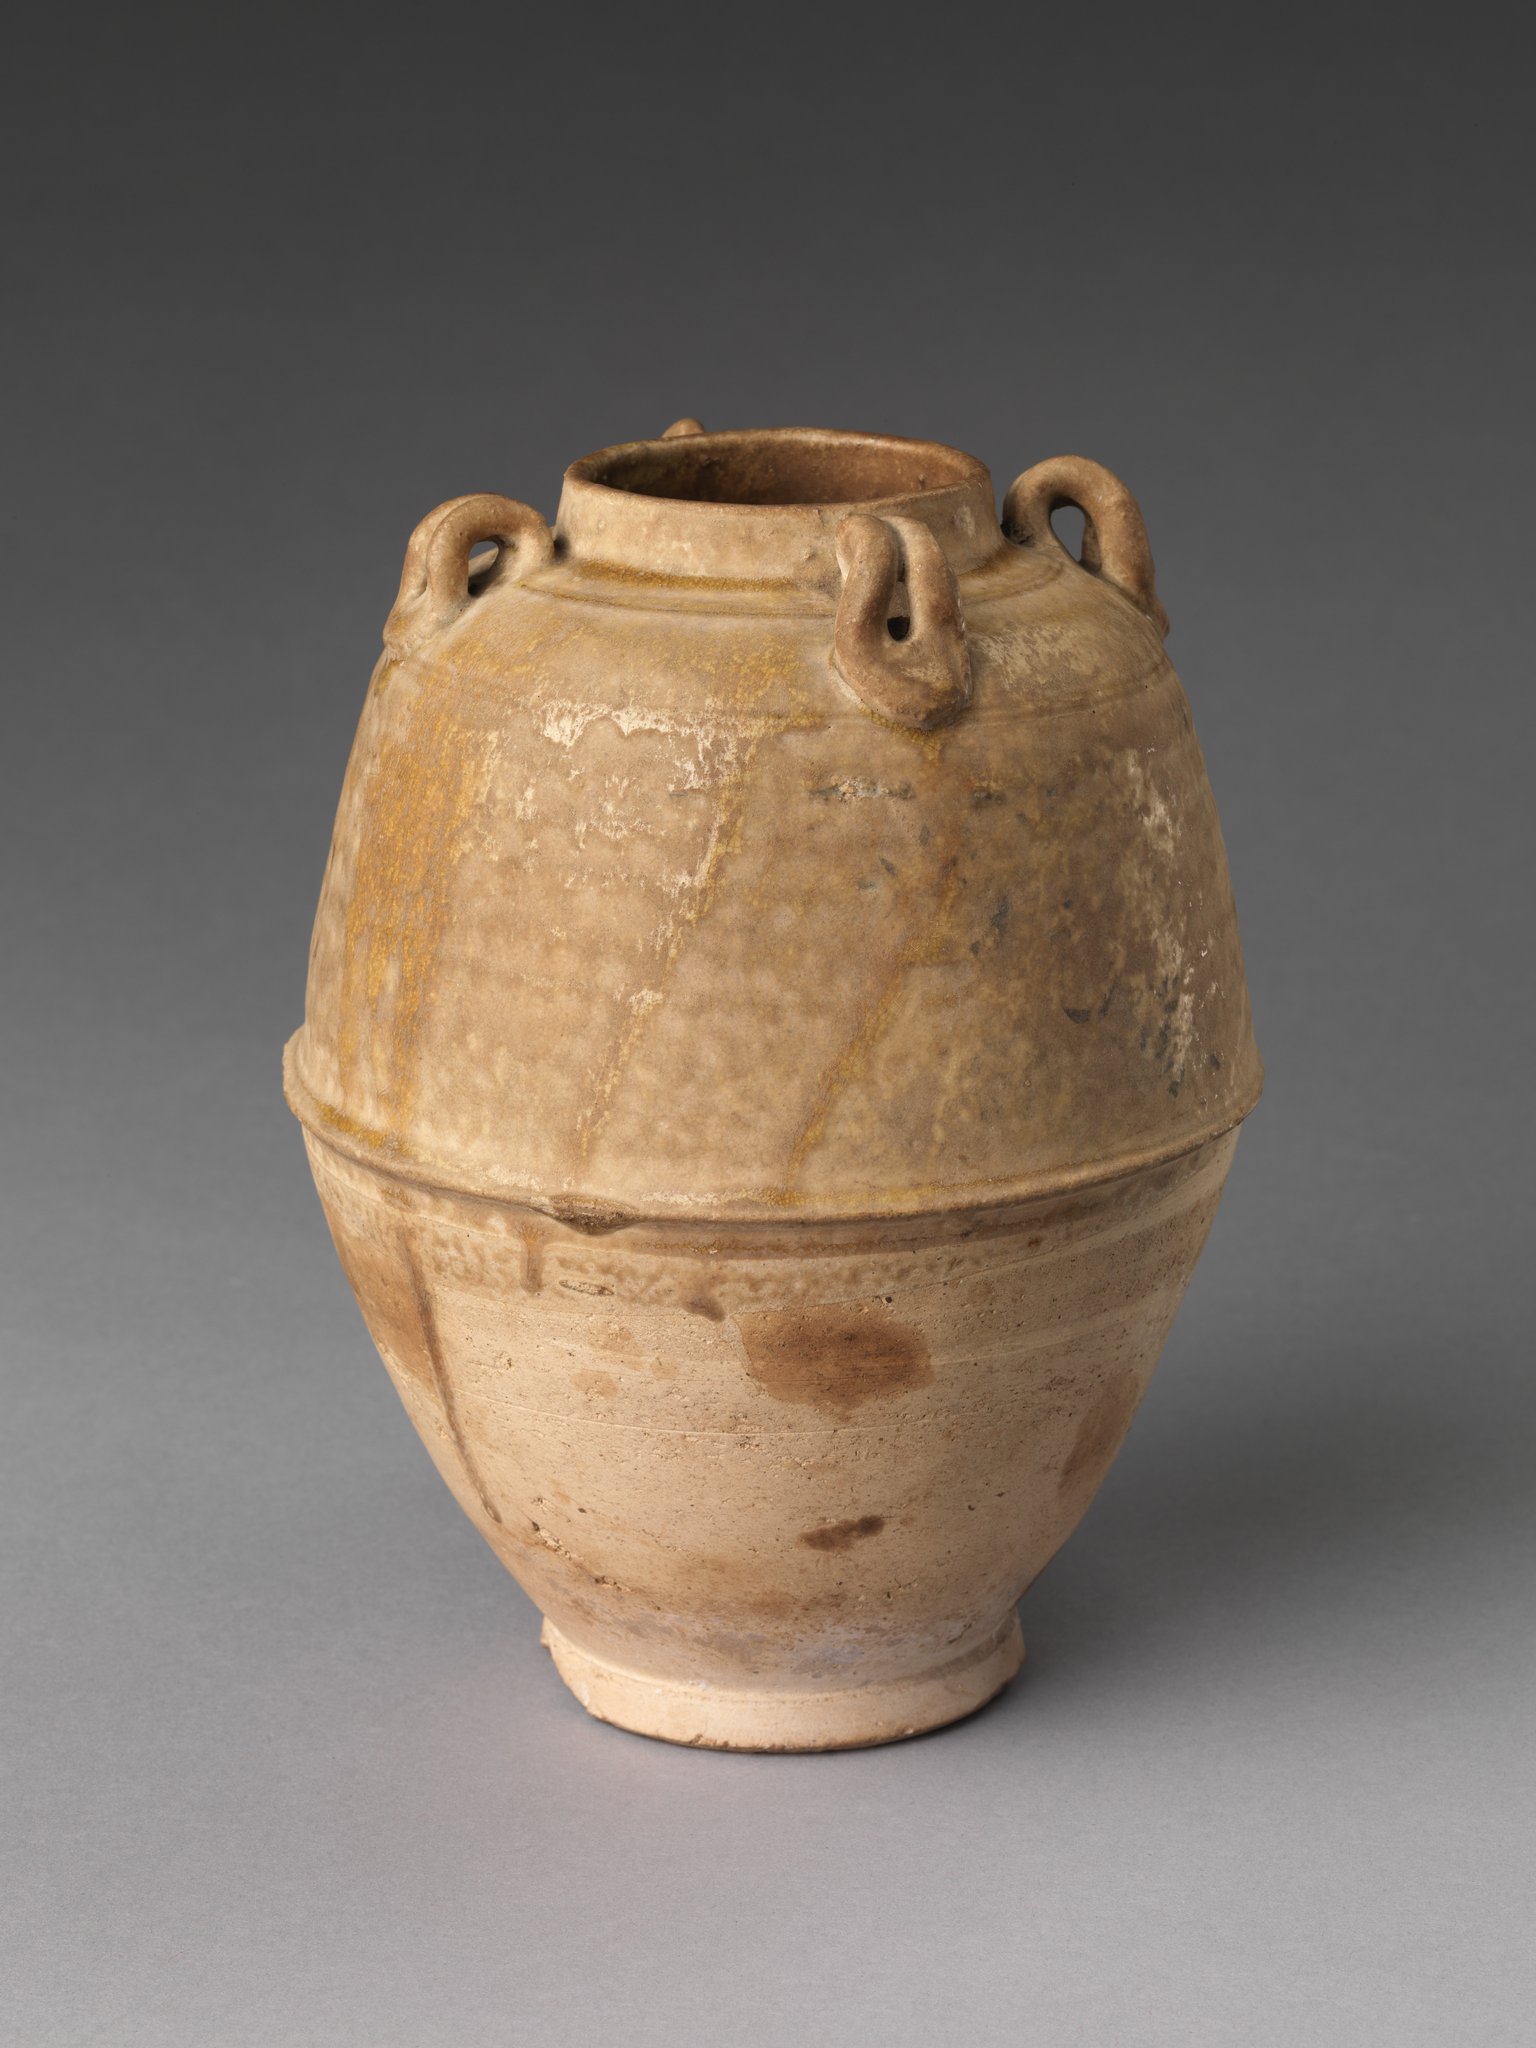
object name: jar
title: Jar with four lugs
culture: chinese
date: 567-600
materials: glaze, stoneware